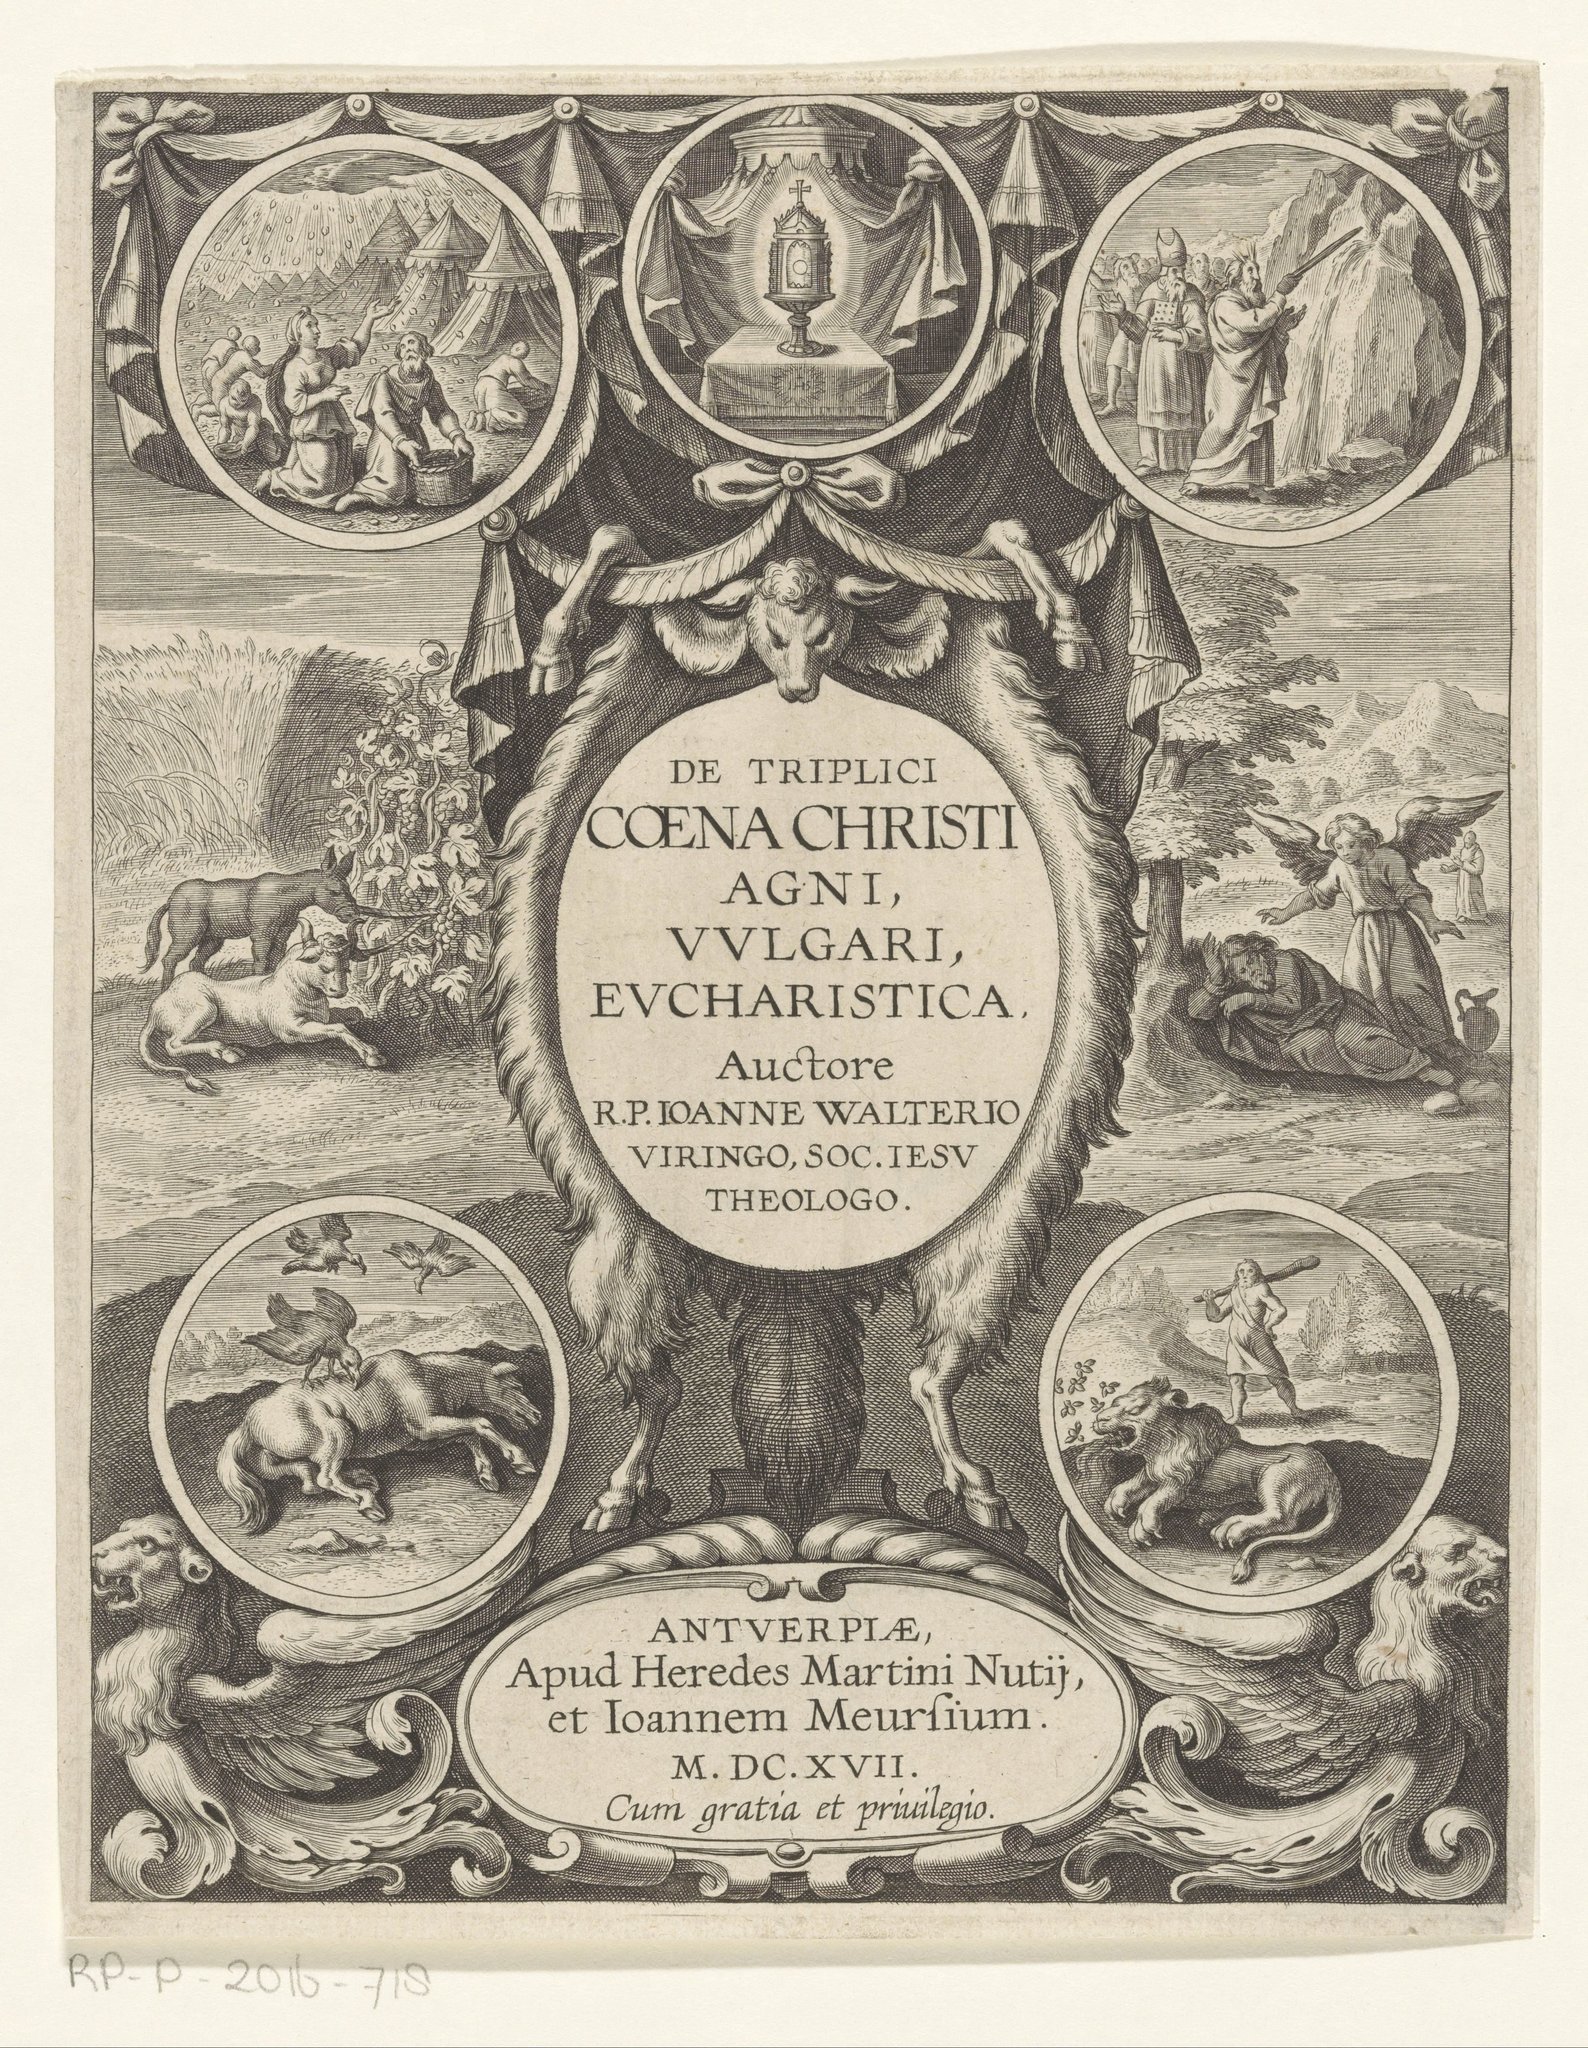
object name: titelblad, titelpagina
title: Titelpagina voor: Joannes Walter Vieringen, De triplici coena Christi agni, vulgari, eucharistica, 1617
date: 1617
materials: paper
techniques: engraving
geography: antwerp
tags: glorification, triumph of the eucharist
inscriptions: collector's mark: Lugt 2760, collector's mark: Lugt 2228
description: Titelpagina voor: Walter Vieringen, Johannes. De triplici coena Christi agni, vulgari, eucharistica. Antwerpen: Meurs, Johannes van en Nutius, Martinus (II, erven), 1617.